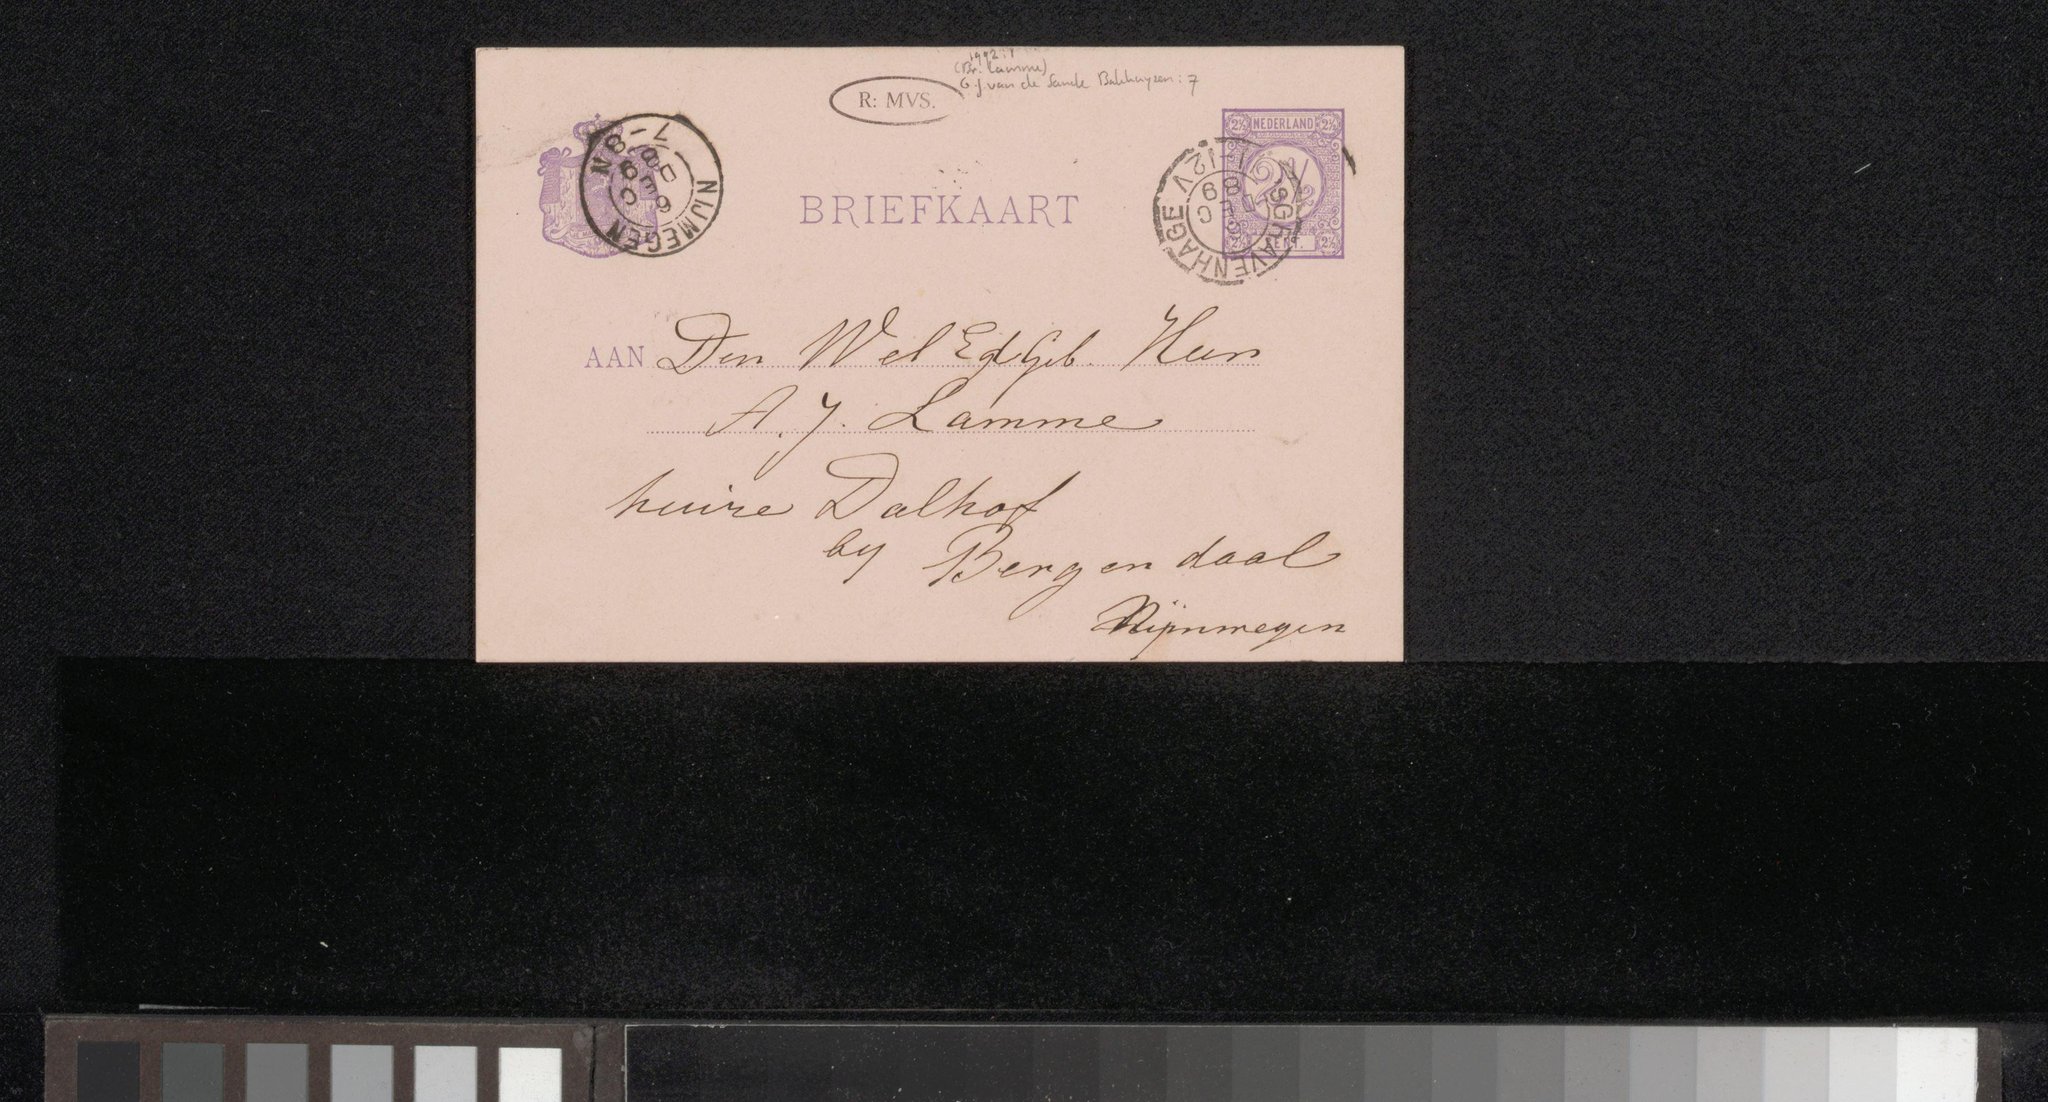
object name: postcard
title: Briefkaart aan Ary Johannes Lamme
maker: julius jacobus van de sande bakhuyzen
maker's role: draughtsman, painter, print maker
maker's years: 1835-1925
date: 1889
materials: cardboard, ink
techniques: pen, writing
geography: the hague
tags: print maker, ary johannes lamme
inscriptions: collector's mark: Lugt 2228